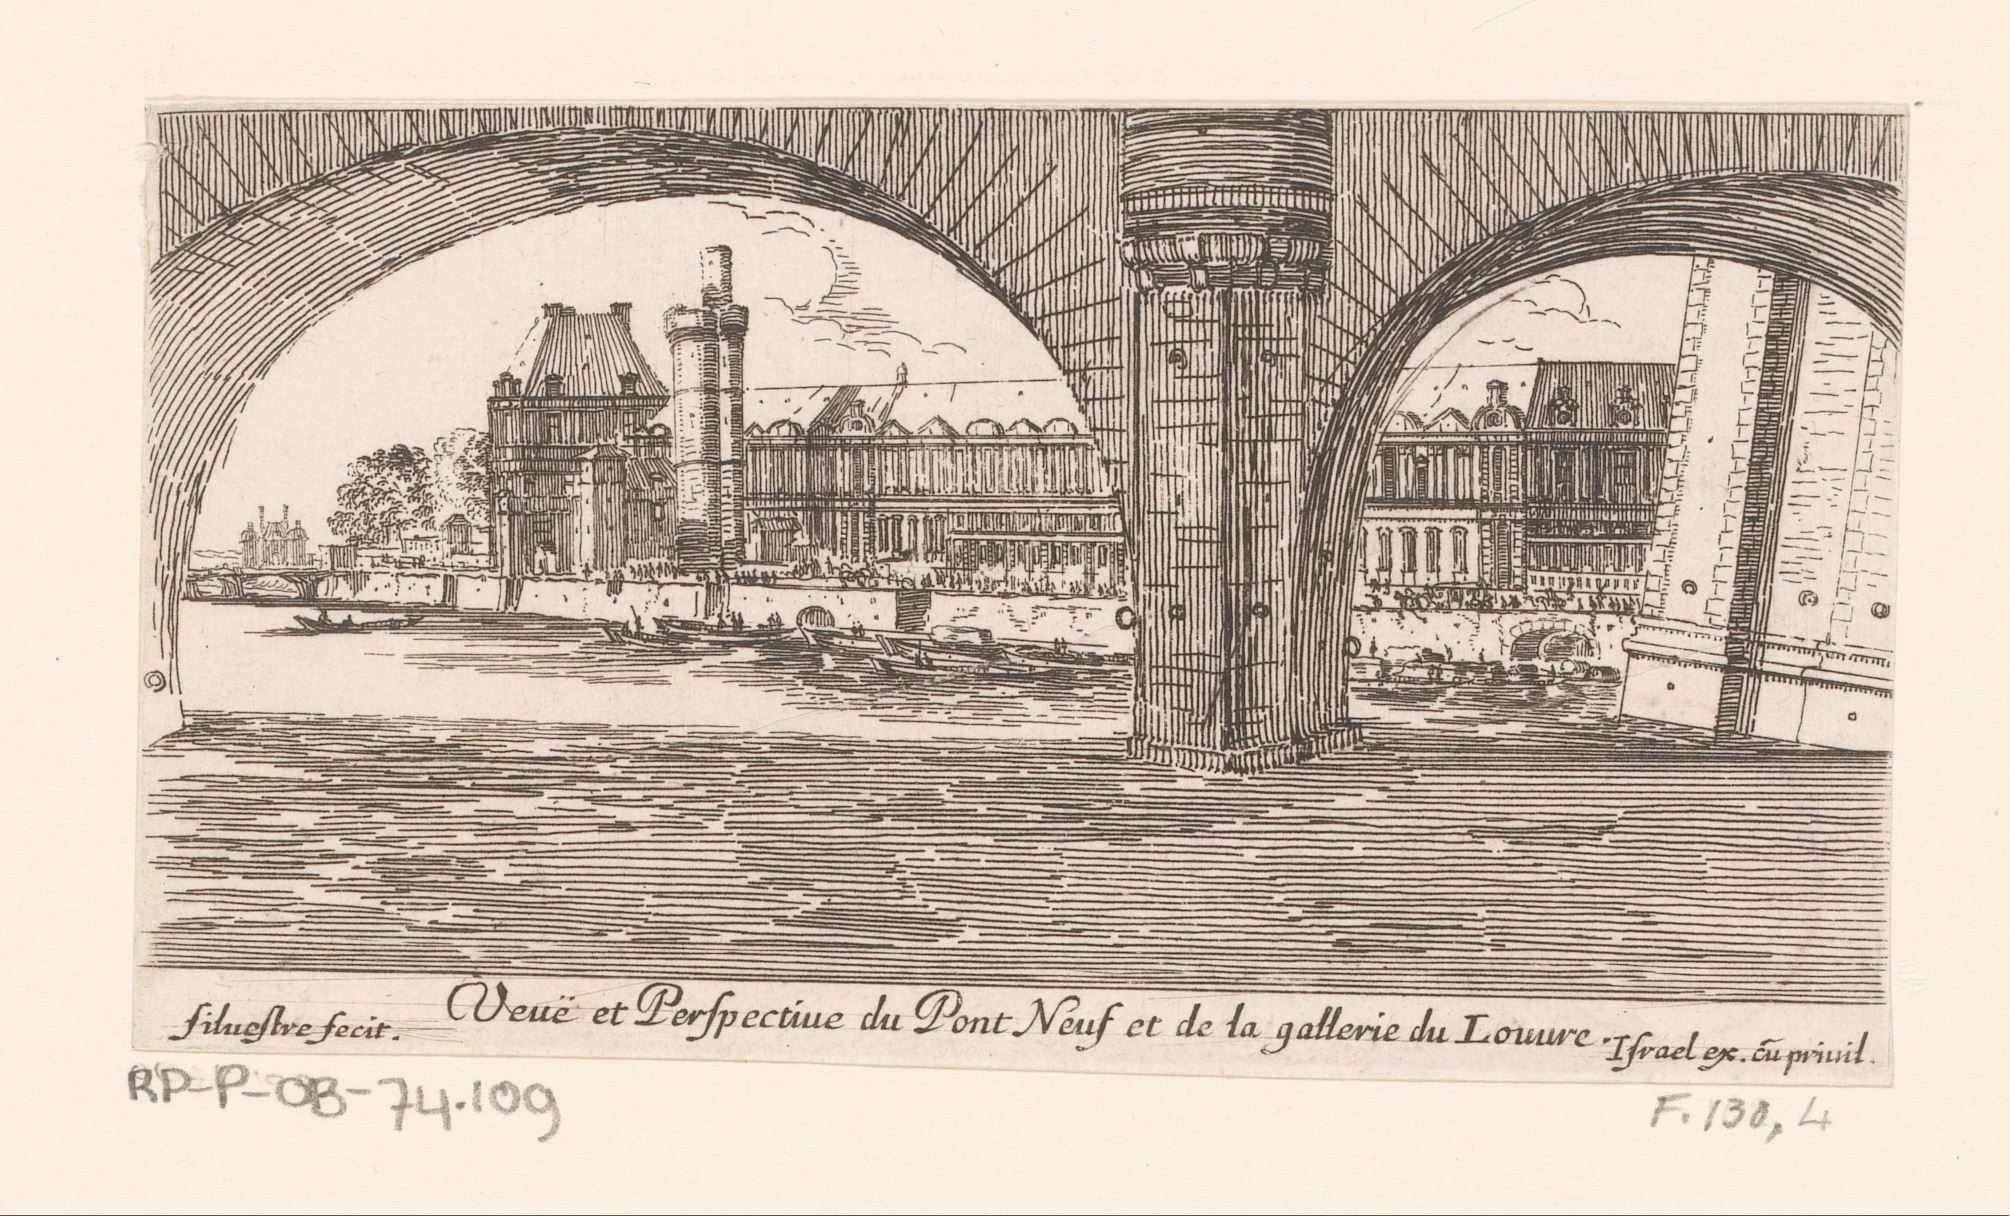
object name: print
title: Gezicht op de Pont Neuf met daarachter de Galerie du Louvre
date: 1631-1661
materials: paper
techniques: etching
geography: france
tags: bridge in city across river, canal, etc.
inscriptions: collector's mark: Lugt 240